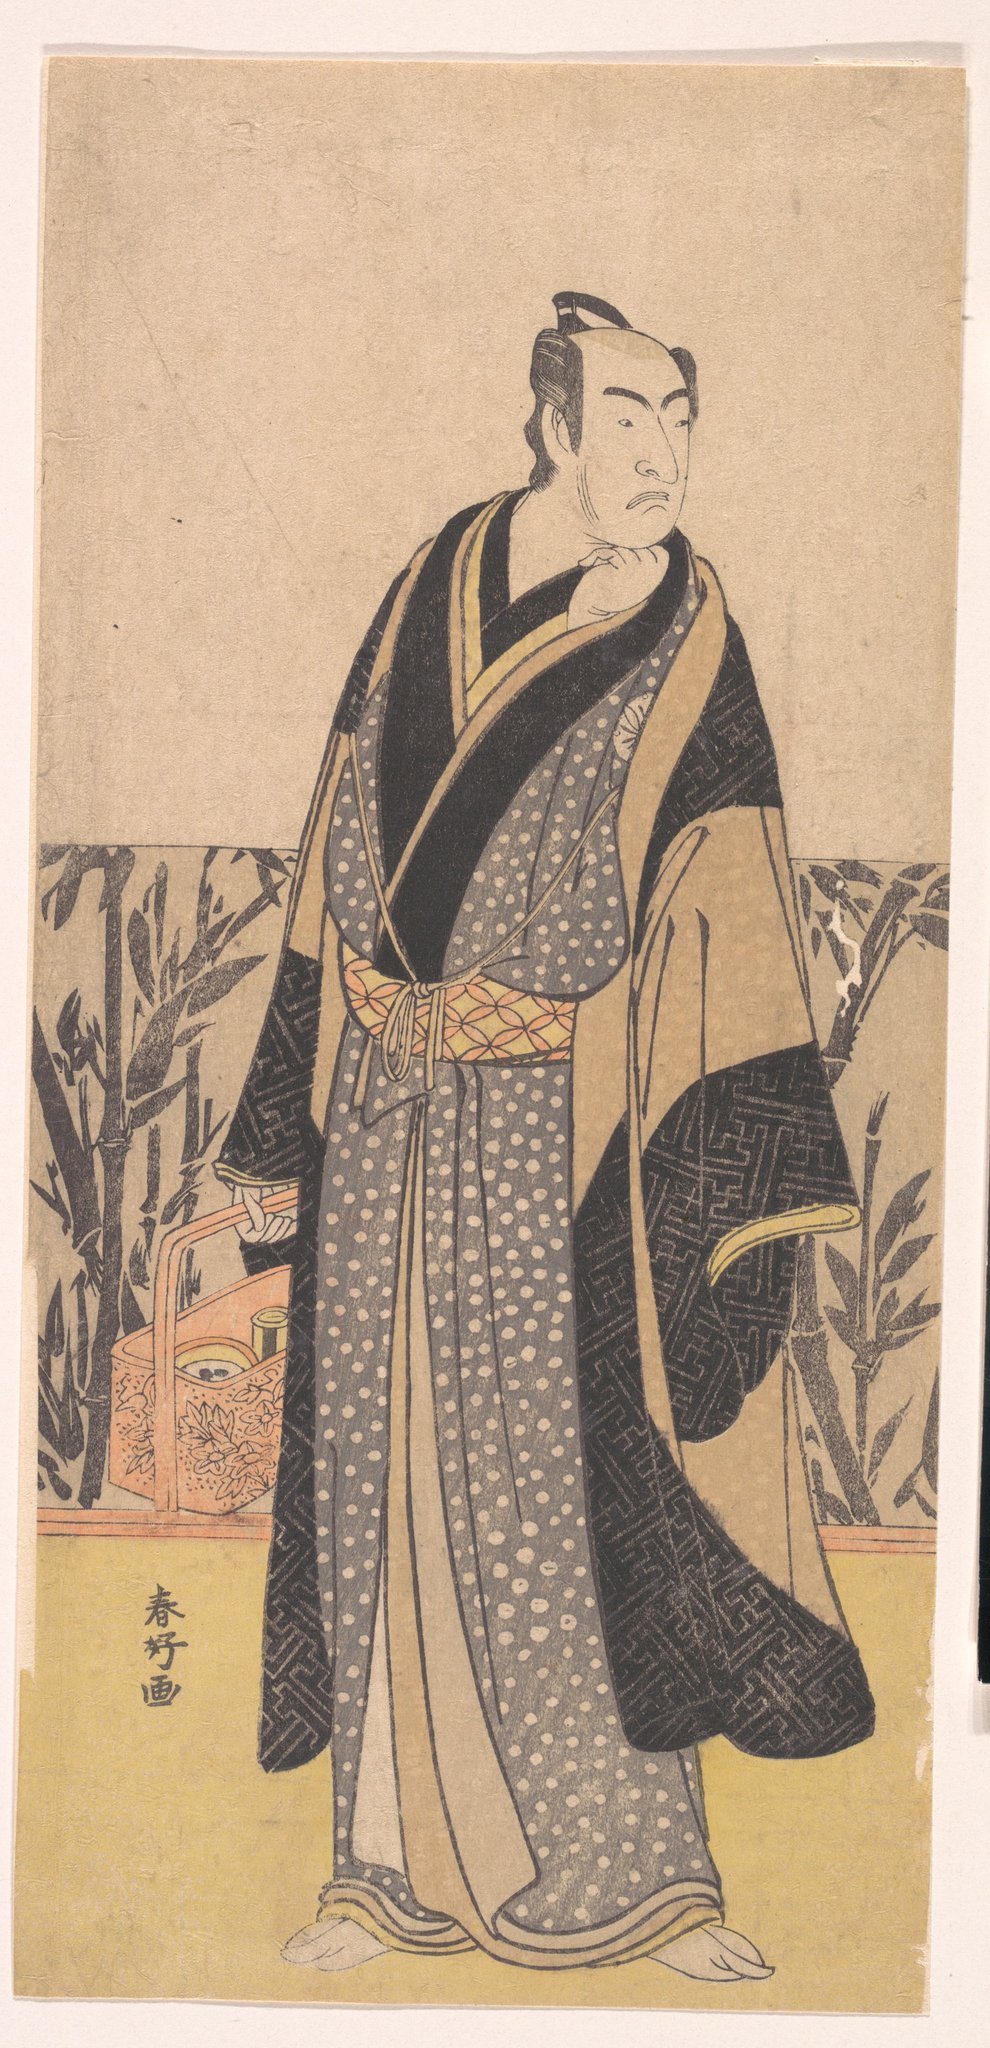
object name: print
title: The Actor, Matsumoto Koshiro I 1674–1730 in an Unidentified Role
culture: japanese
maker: katsukawa shunkō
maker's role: artist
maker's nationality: japanese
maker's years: 1743-1812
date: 1743-1812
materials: ink, paper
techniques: woodblock print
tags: men,actors